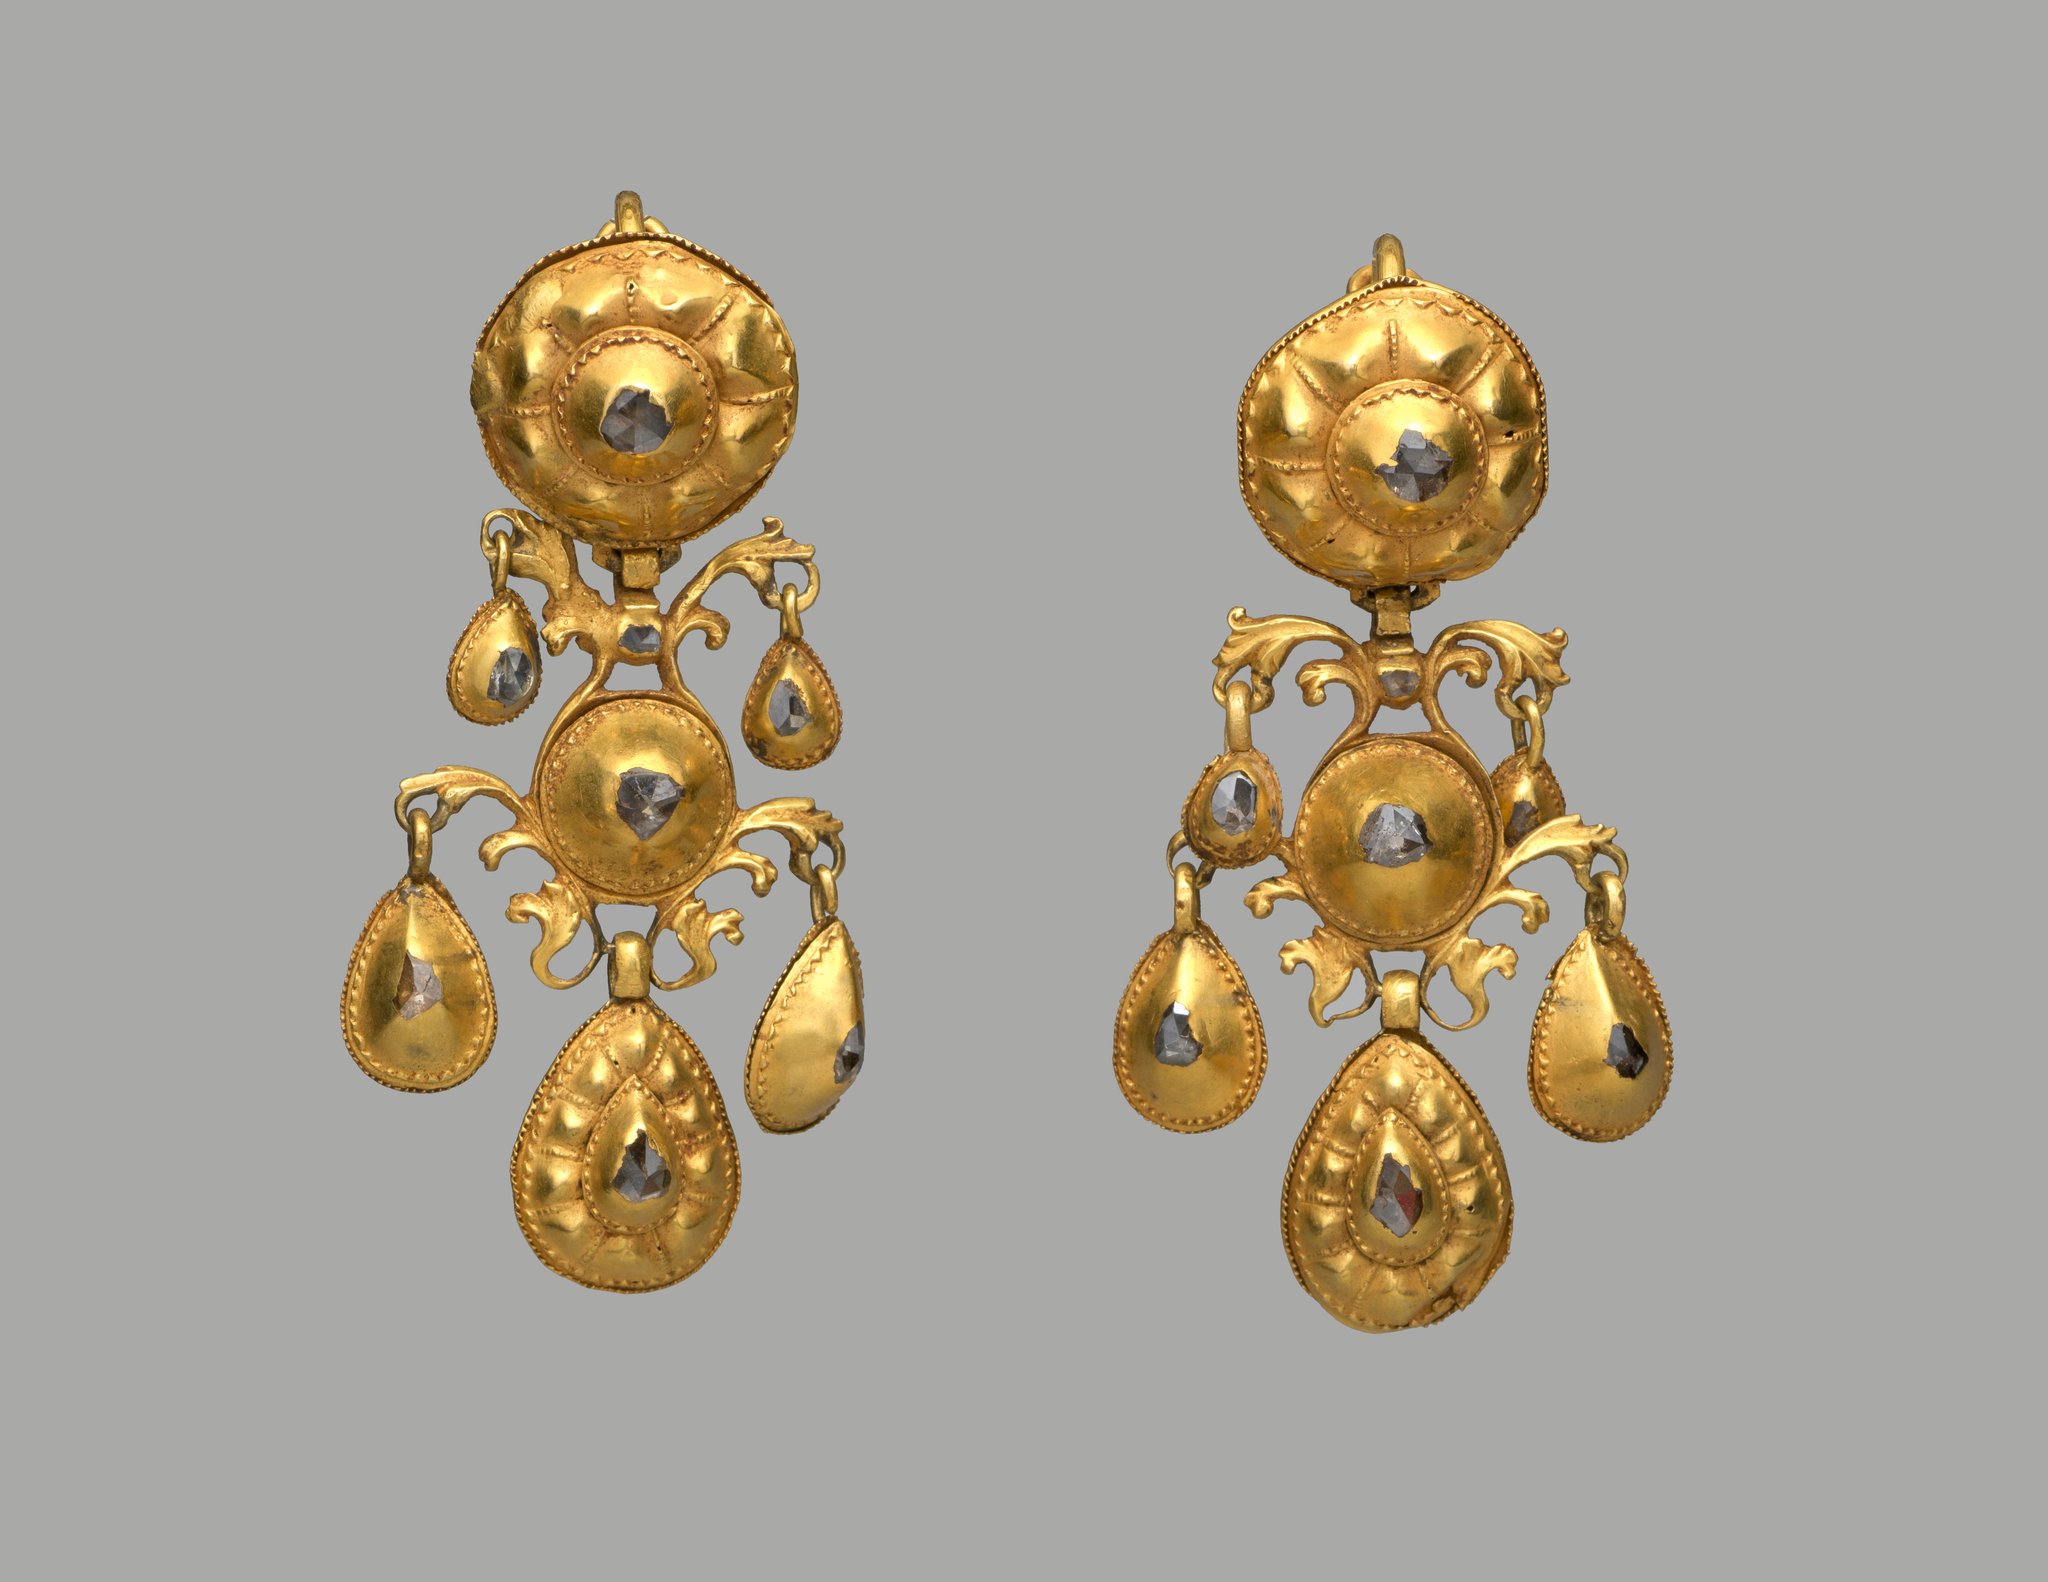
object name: earring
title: Pair of earrings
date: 1701-1800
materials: diamond, gold